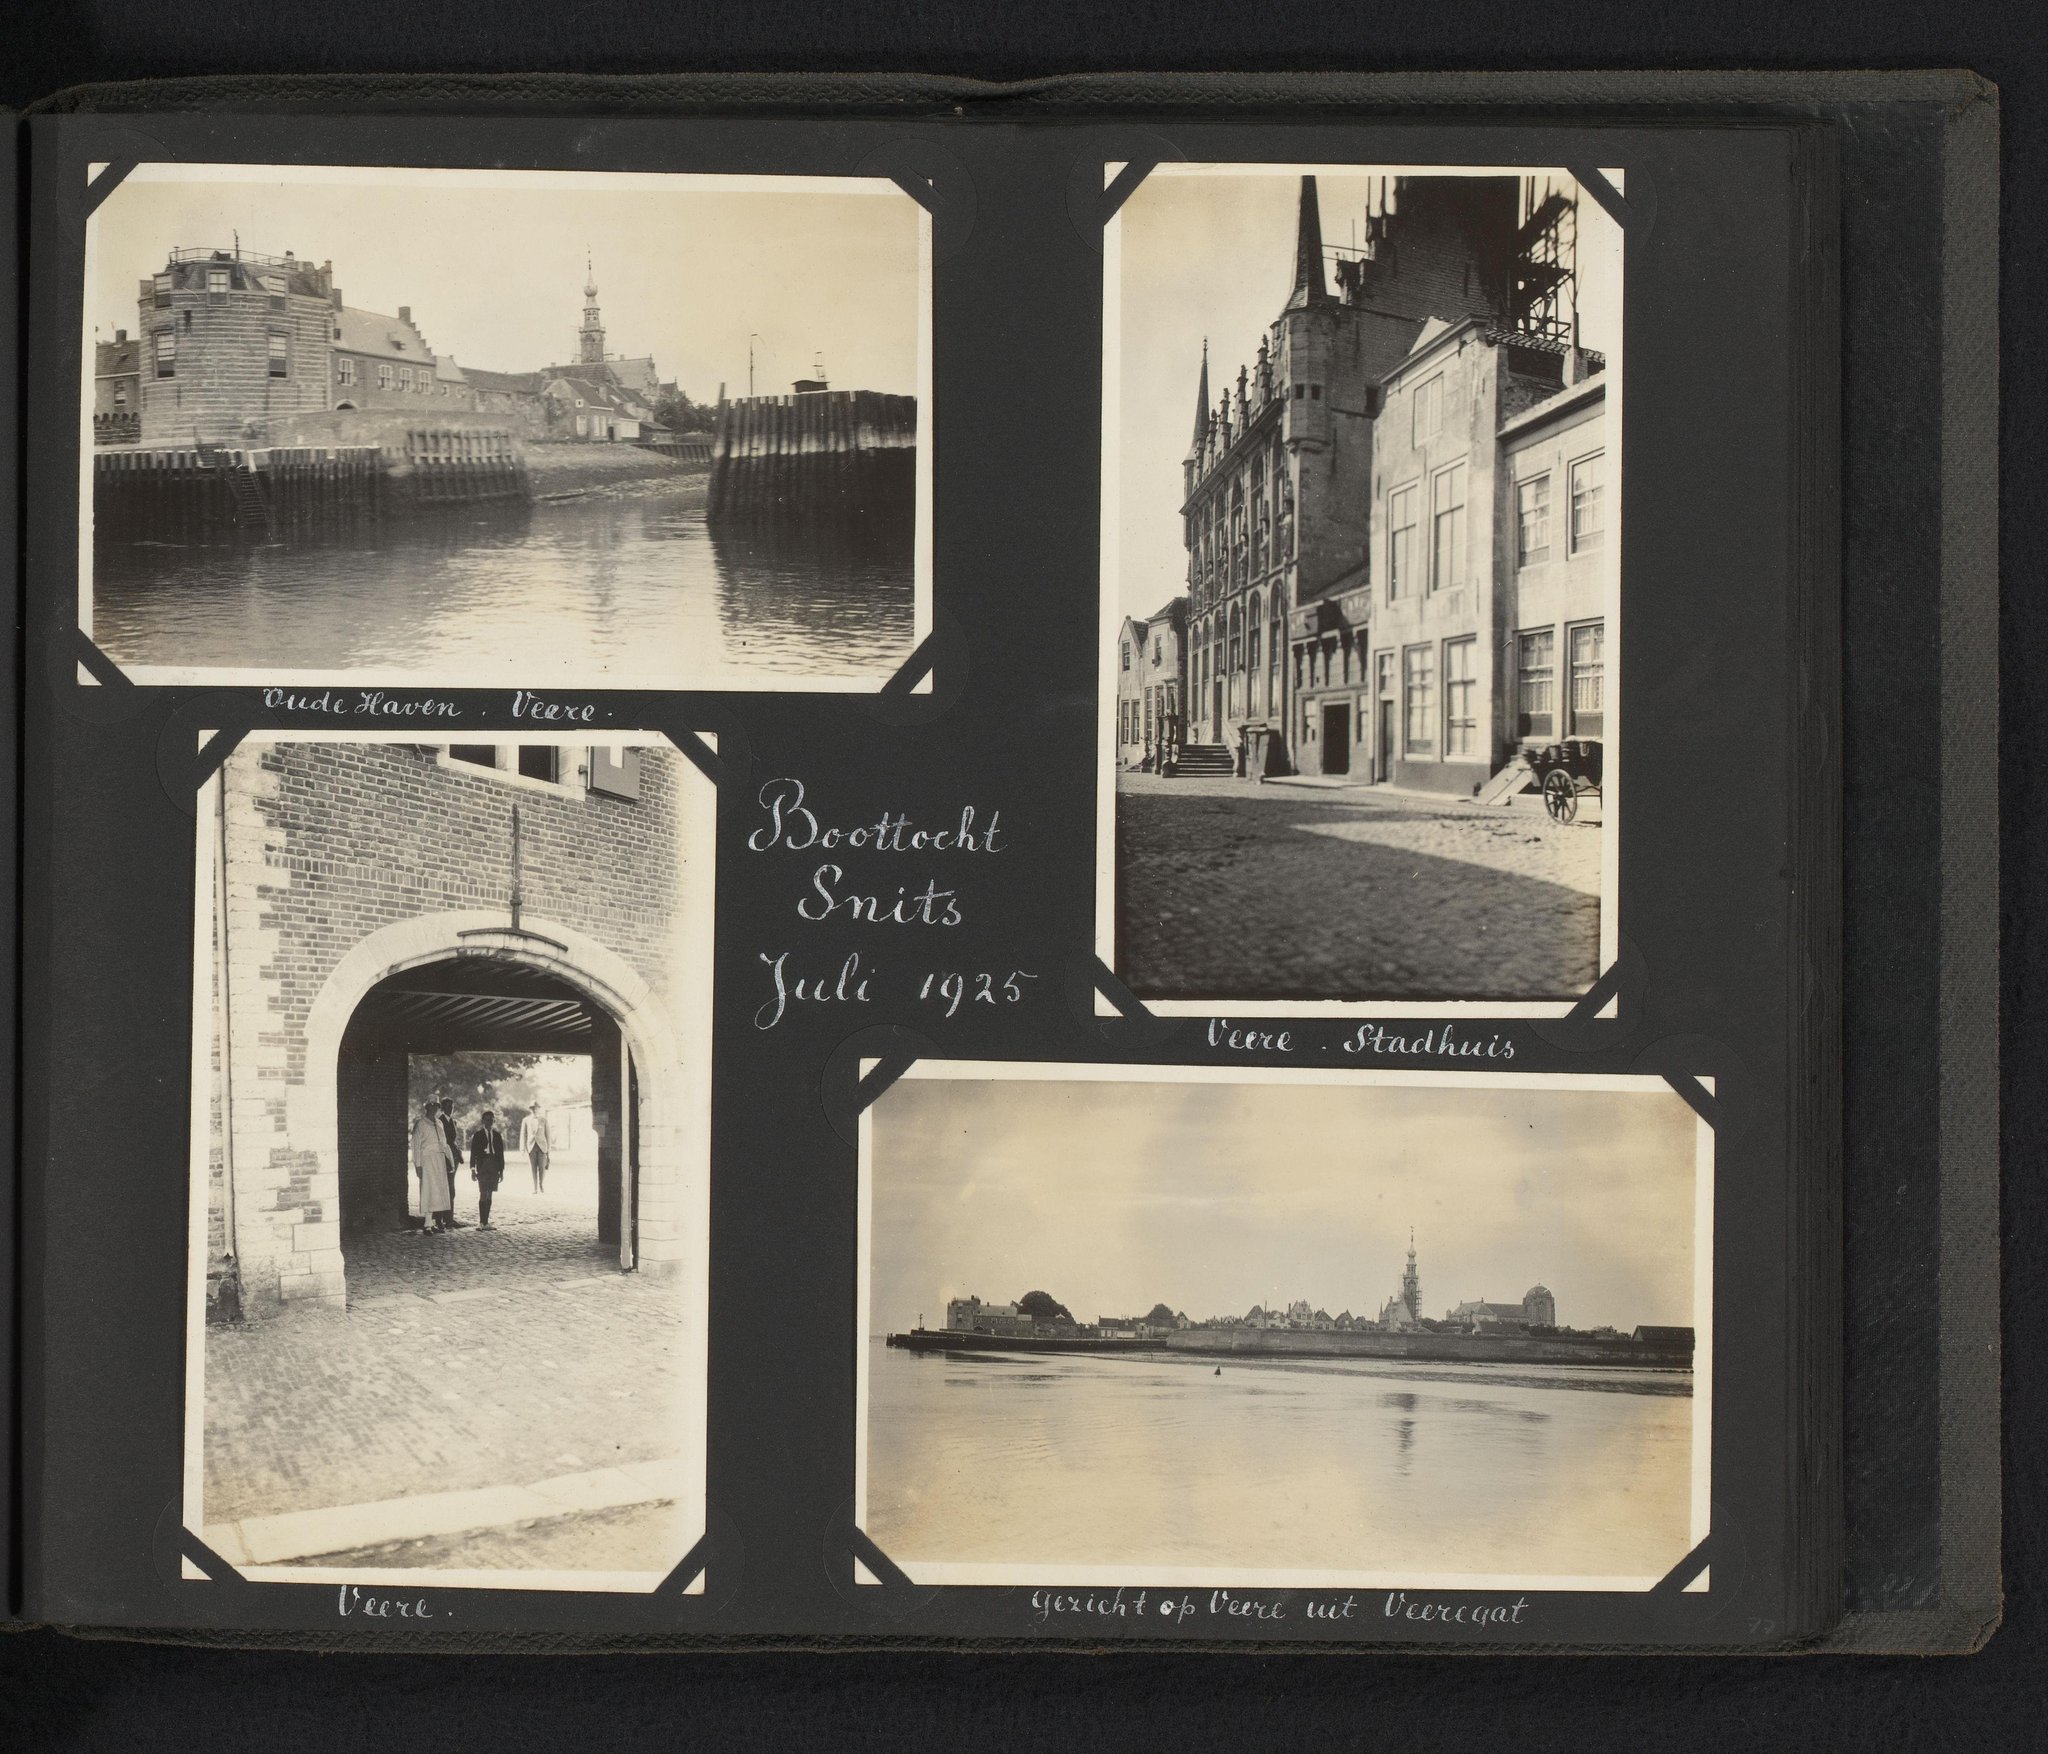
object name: album leaf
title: Vier foto's van Veere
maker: hendrik herman van den berg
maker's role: amateurfotograaf, jurist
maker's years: 1875-1944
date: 1907-1925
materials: paper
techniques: gelatin silver print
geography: veere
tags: tower, clock tower ~ monumental adornment, city-view in general; 'veduta'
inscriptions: inscription: ‘Oude Haven - Veere’, inscription: ‘Gezicht op Veere uit Veeregat’, inscription: ‘Veere’, inscription: ‘Veere - Stadhuis’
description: Deze foto's maken deel uit van een album.